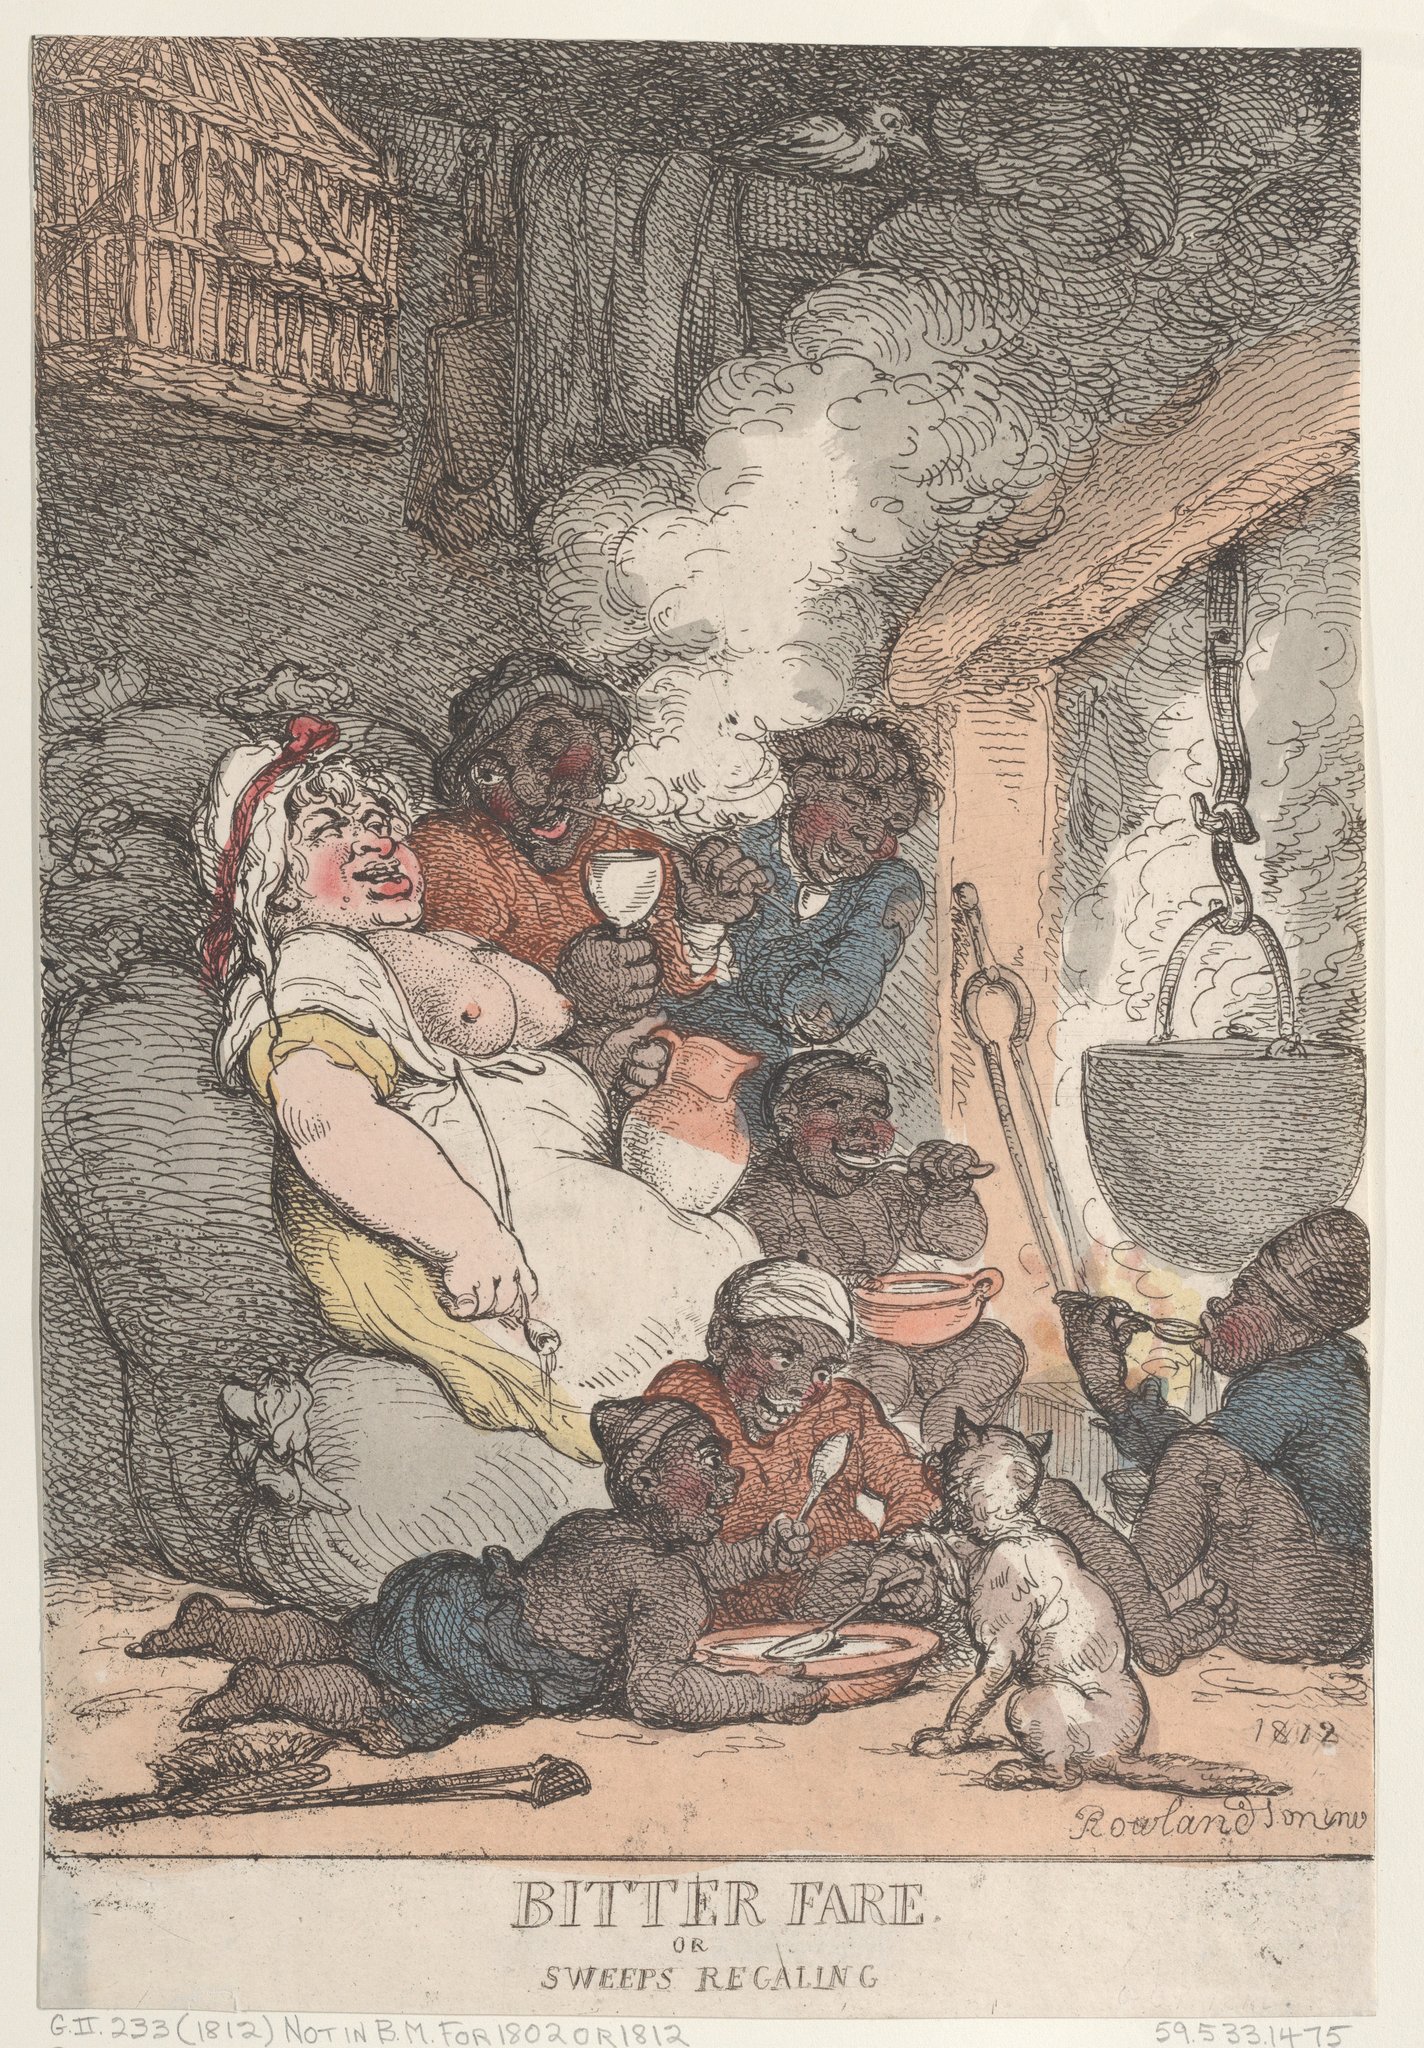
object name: print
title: Bitter Fare or Sweeps Regaling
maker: thomas rowlandson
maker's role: artist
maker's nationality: british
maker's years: 1757-1827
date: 1812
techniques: etching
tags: satire,men,women,smoking,eating